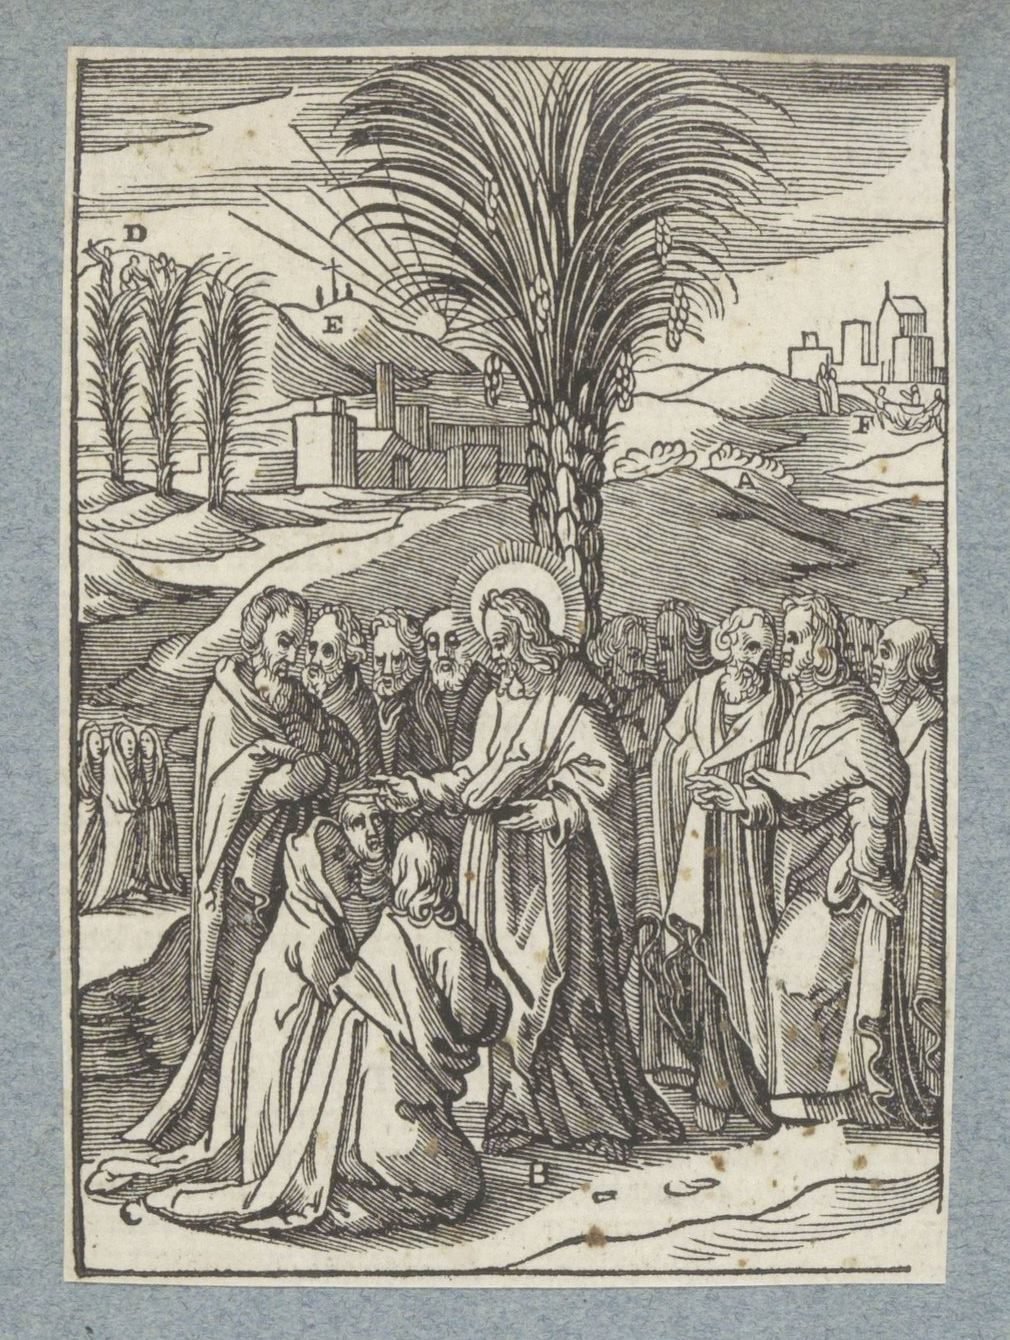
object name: album leaf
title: Christus en de moeder van de zonen van Zebedeüs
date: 1629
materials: paper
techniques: letterpress printing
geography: antwerp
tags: request of the mother of the sons of zebedee (matthew 20:20-21)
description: De moeder van de zonen van Zebedeüs knielt met haar zonen voor Christus. De vrouw vraagt Christus of haar zonen in zijn koninkrijk naast hem mogen zitten. De leerlingen van Christus kijken toe. Bij verschillende elementen uit de voorstelling staan letters. Bij D wordt Jacobus in opdracht van Herodus Agrippa onthoofd, E toont de Kruisiging van Christus en bij F zit Johannes in een ketel met kokende olie. De prent maakt deel uit van een album.